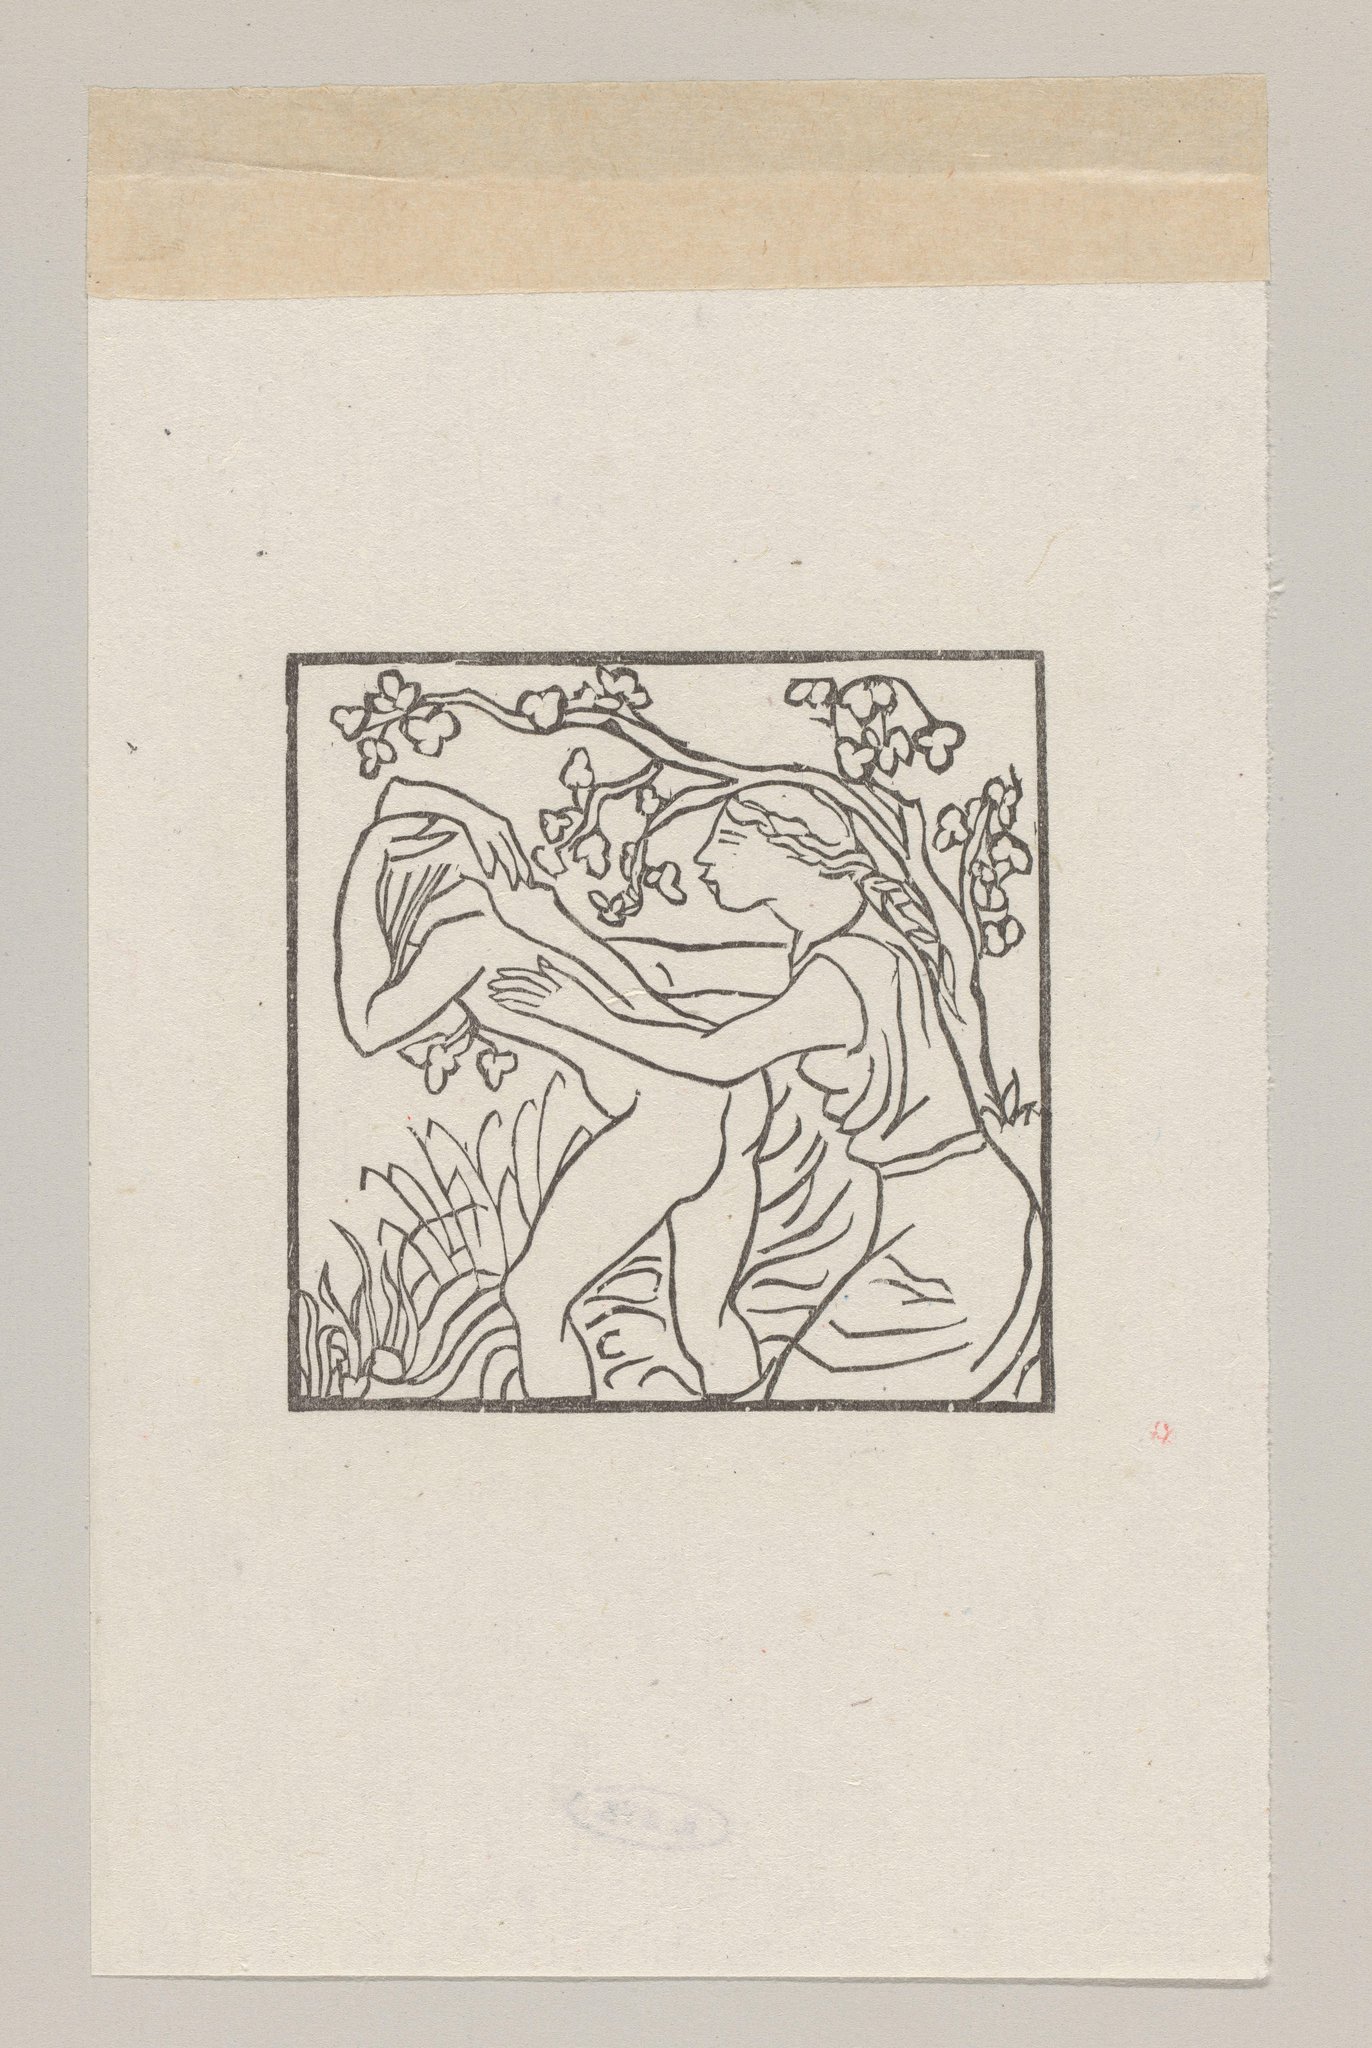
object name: print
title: Chloé lave Daphnis dans la caverne des nymphes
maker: aristide maillol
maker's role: draughtsman, painter, print maker, sculptor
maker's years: 1861-1944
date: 1937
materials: paper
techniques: woodcut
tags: washing and bathing - aa - in the open air (+ two together), daphnis (in greek mythology a shepherd who invented pastoral poetry, chloe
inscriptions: collector's mark: Lugt 2228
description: Latere staat van deze prent gebruikt in: Longus. Les Pastorales de Longus ou Daphnis & Chloé. Parijs: Frères Gonin, 1935, p. 26.